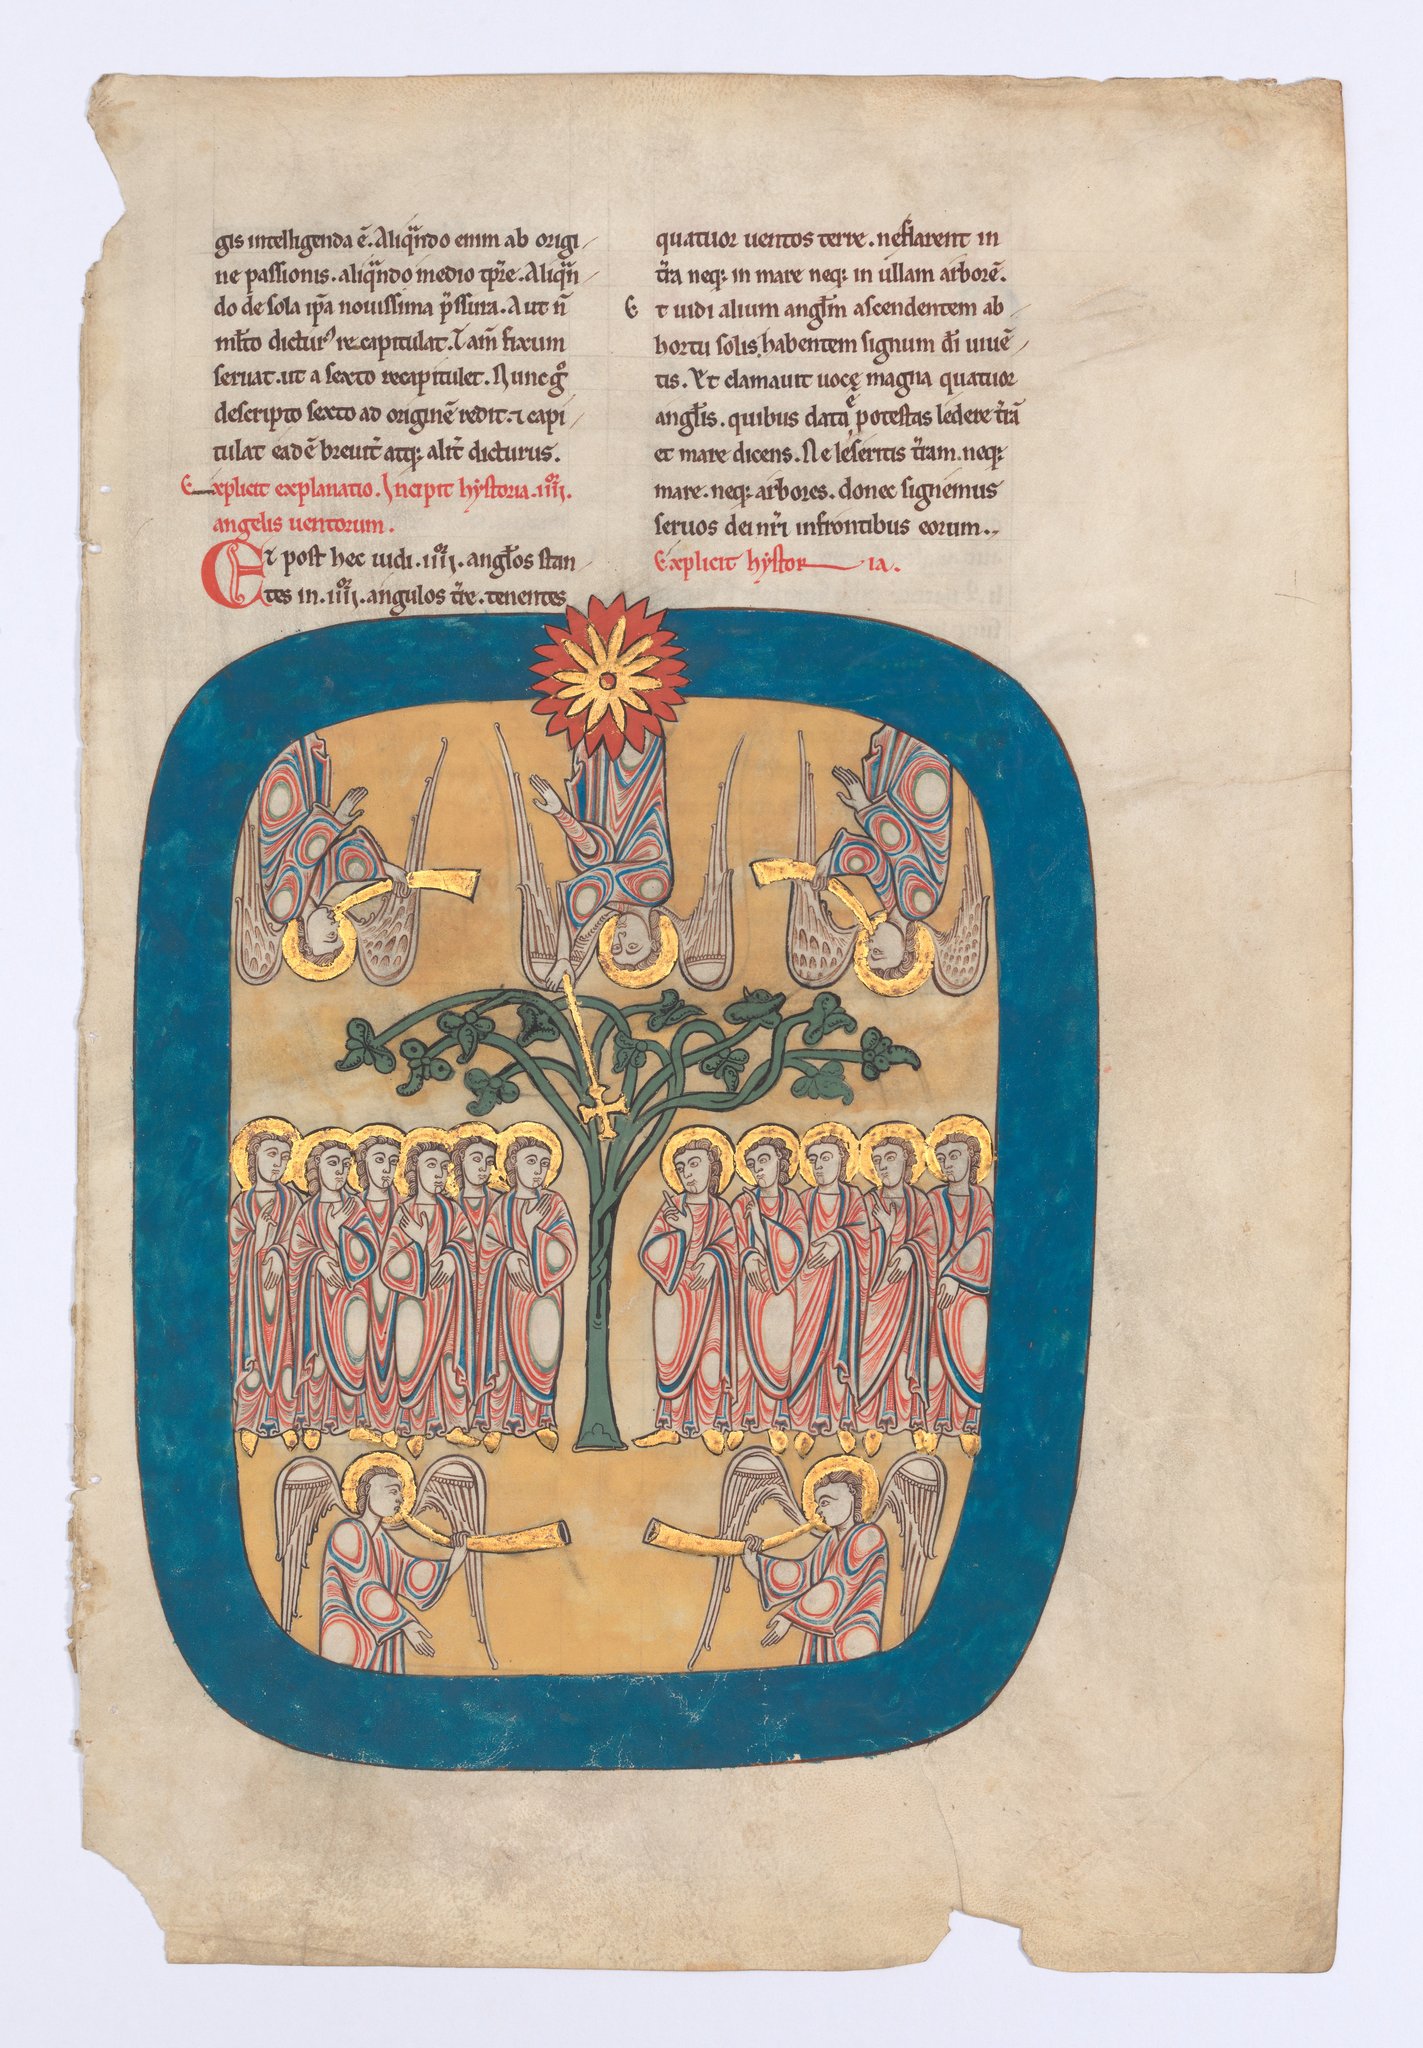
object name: beatus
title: Leaf from a Beatus Manuscript: Angels Restrain the Four Winds; the Angel Ascends from the Rising Sun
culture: spanish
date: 1180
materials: gold, ink, parchment, paint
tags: angels